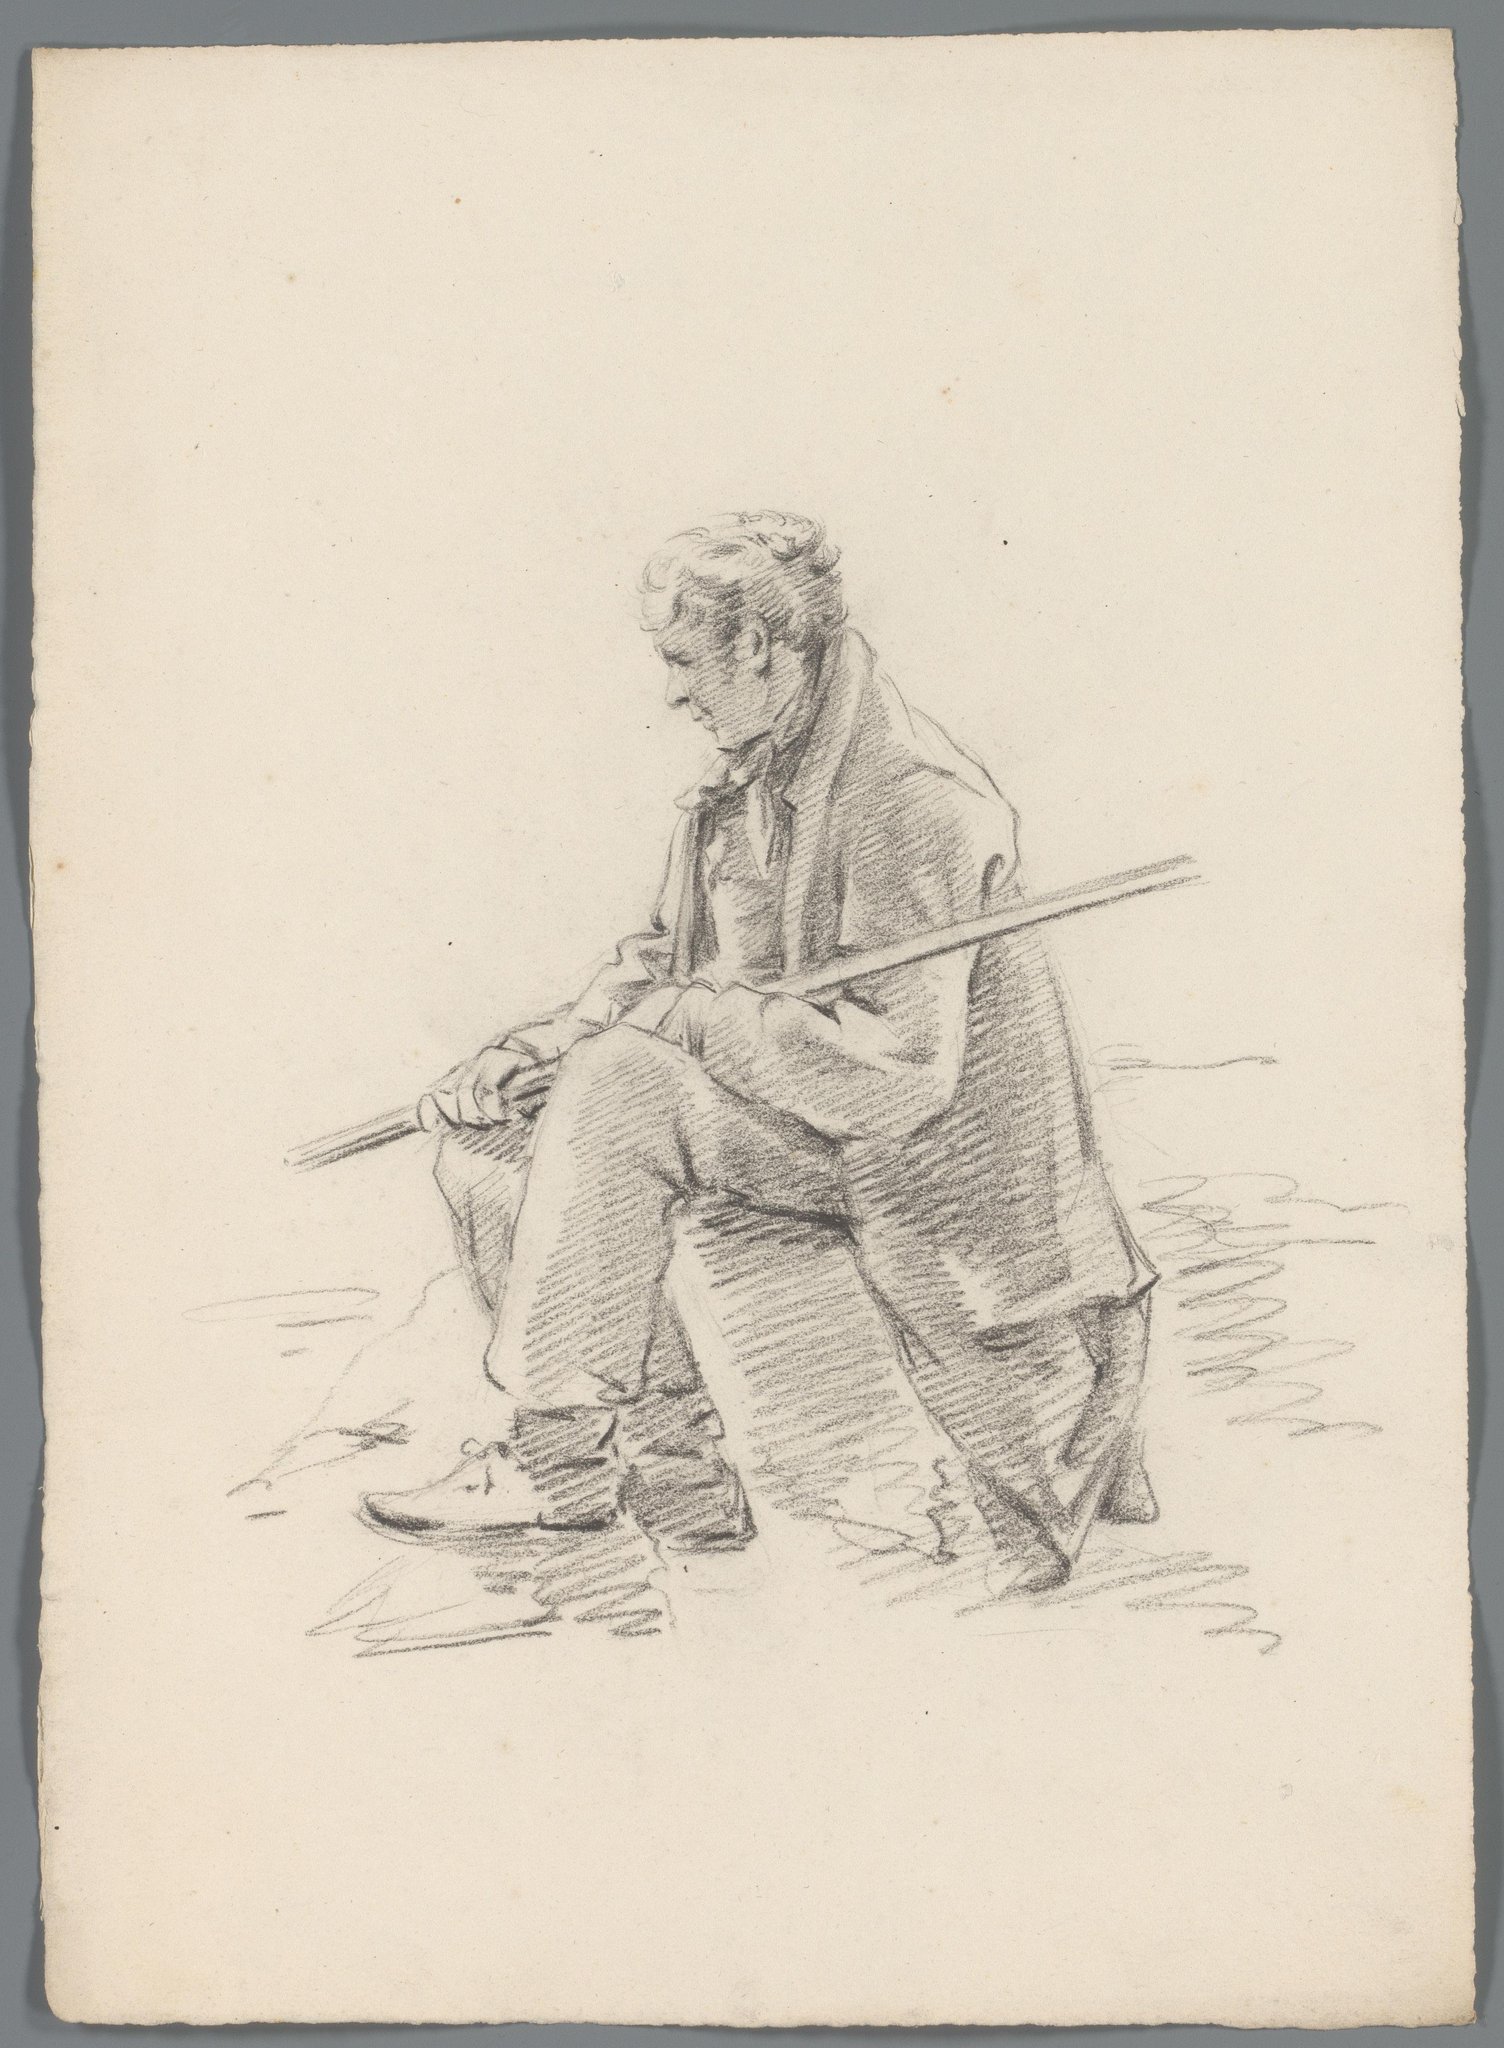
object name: drawing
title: Zittende man met een stok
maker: Anonymous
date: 1820-1830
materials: chalk, paper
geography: the hague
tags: sitting figure, walking-stick, staff, adult man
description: Tekeningen waarschijnlijk ontstaan bij het Haagse kunstgenootschap ‘Tot Nut der Tekenkunst’, waar twee keer per week tekenavonden werden georganiseerd met geklede modellen.